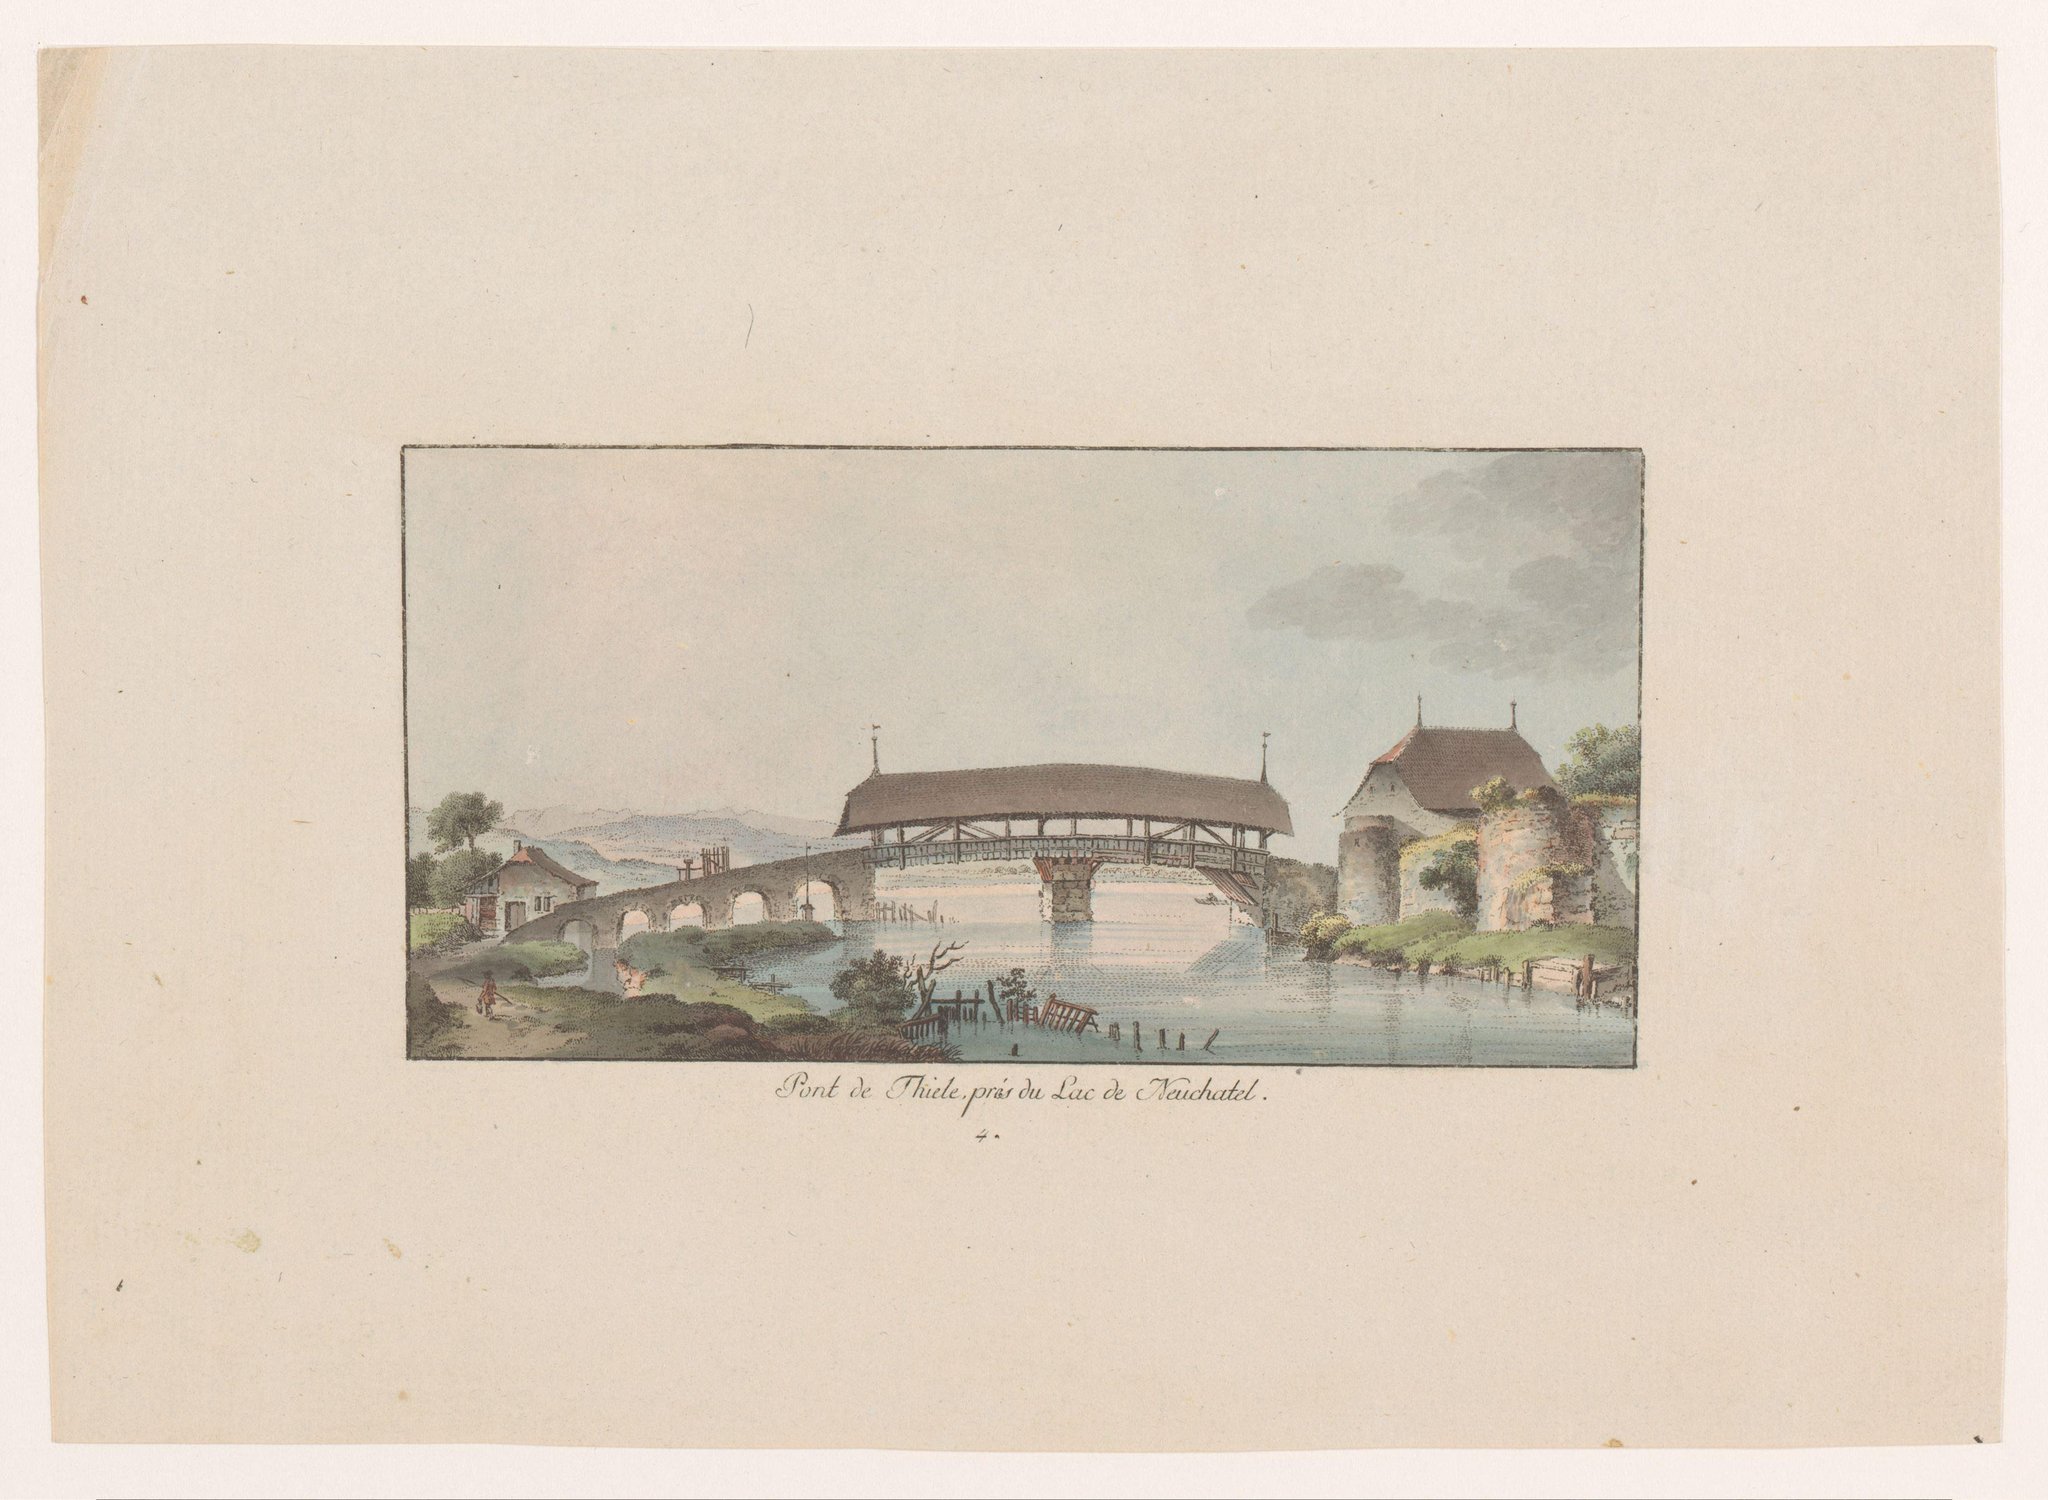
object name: print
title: Collection de quelques vues dessinées en Suisse d'après nature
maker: johann ludwig aberli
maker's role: print maker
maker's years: 1723-1786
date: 1782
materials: paper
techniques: etching, hand coloring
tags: lake, bridge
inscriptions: watermark, collector's mark: Lugt 2228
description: Maakt deel uit van een serie met gezichten op Zwitserland.